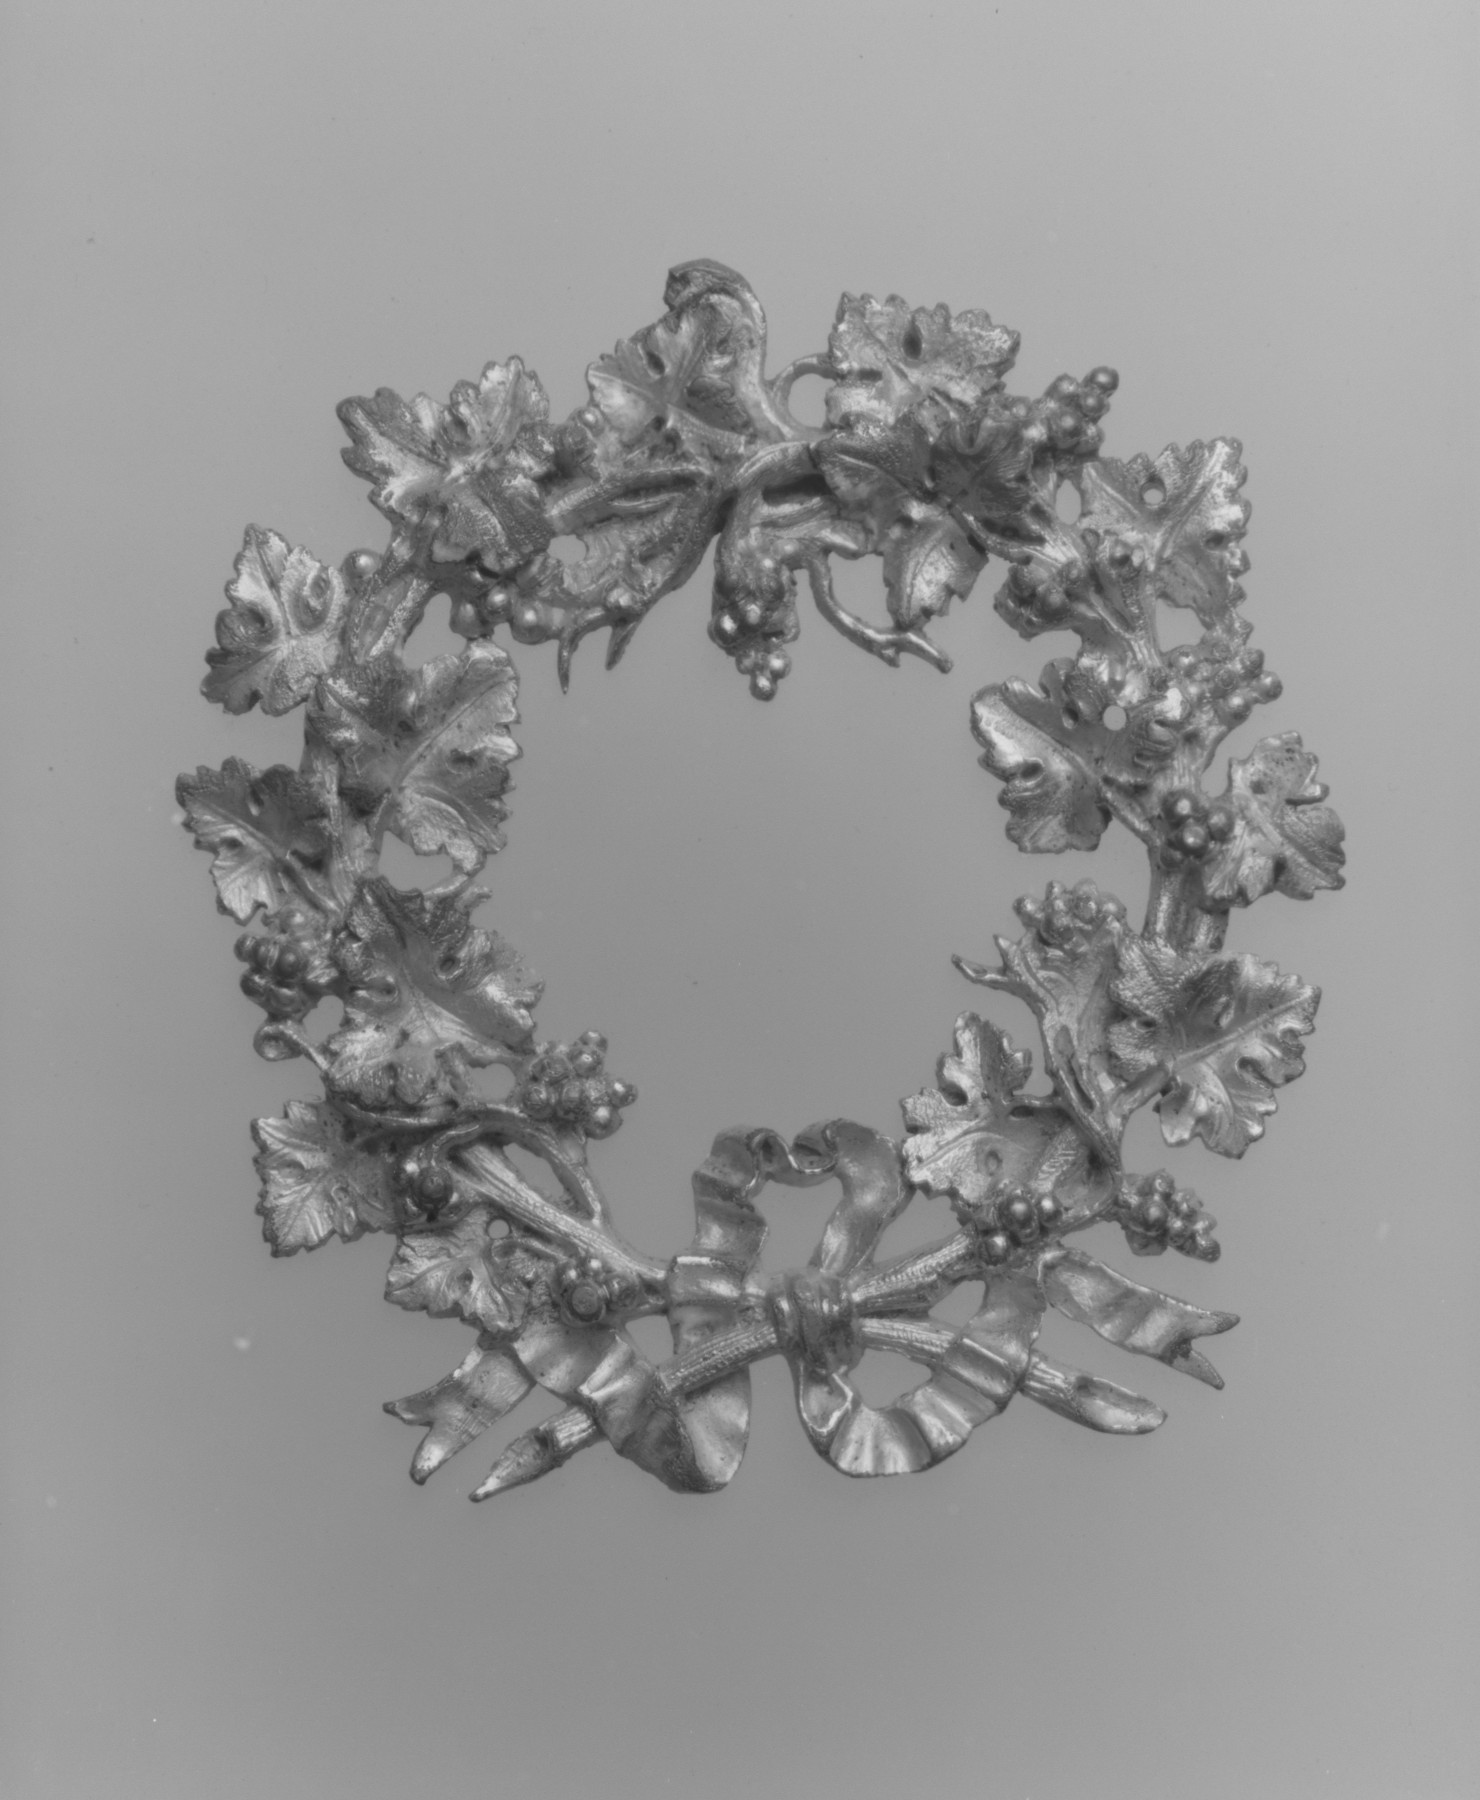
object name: wreath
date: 1701-1800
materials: gilt bronze